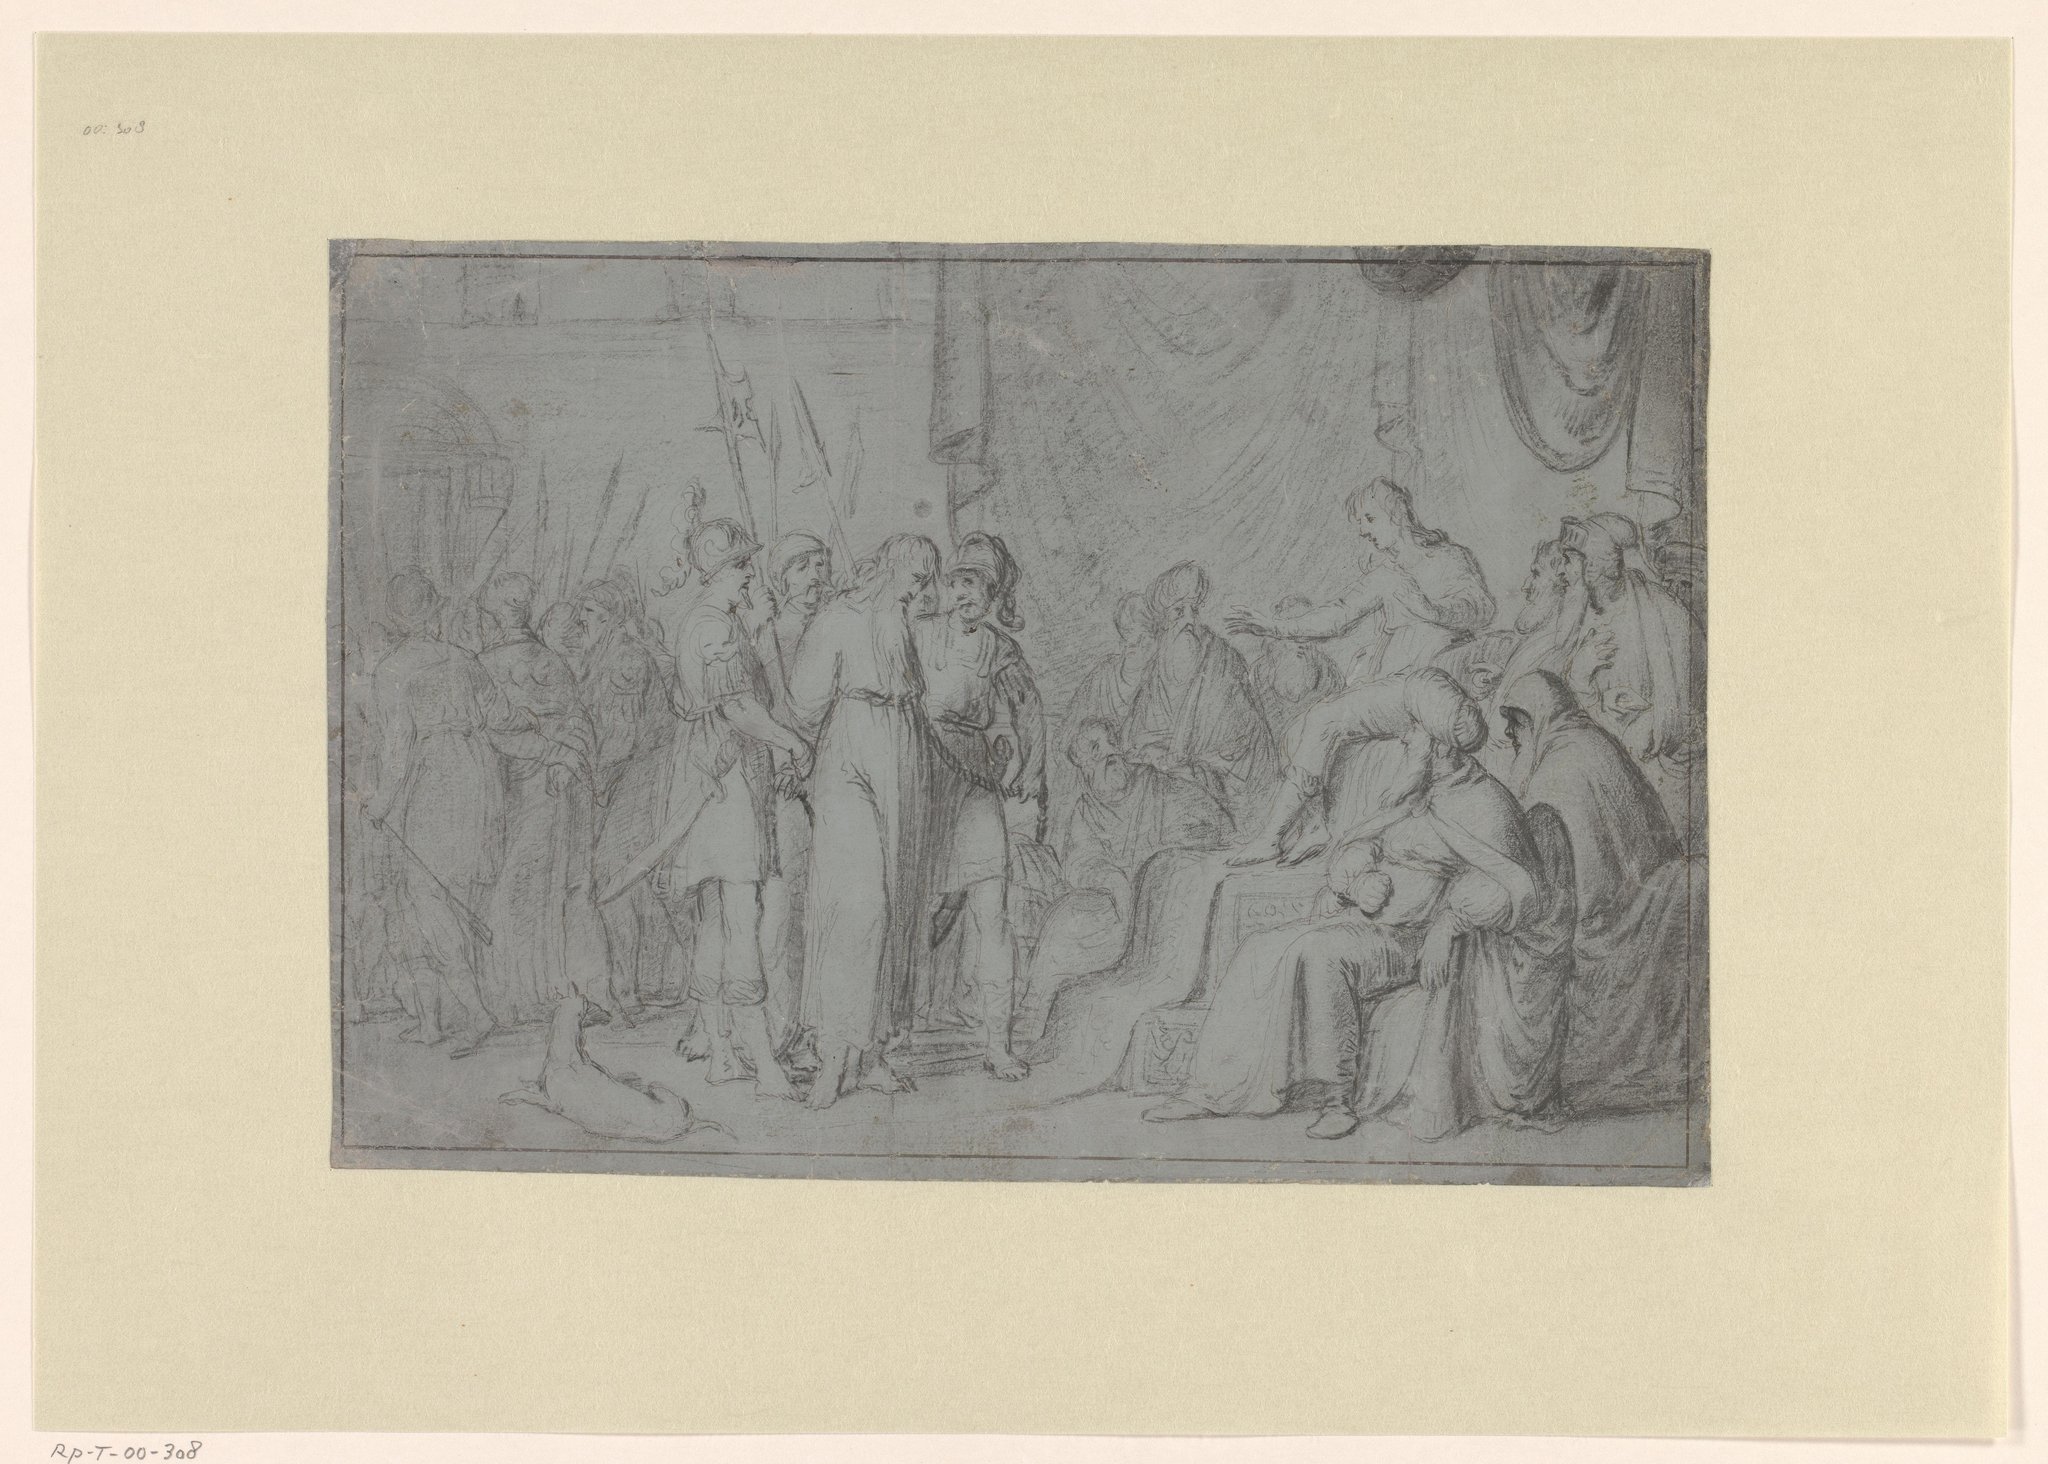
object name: drawing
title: De ouderlingen om beurten voor Daniël geleid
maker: Anonymous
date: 1600-1699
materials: chalk, ink, paper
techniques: pen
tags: daniel interrogates the elders separately